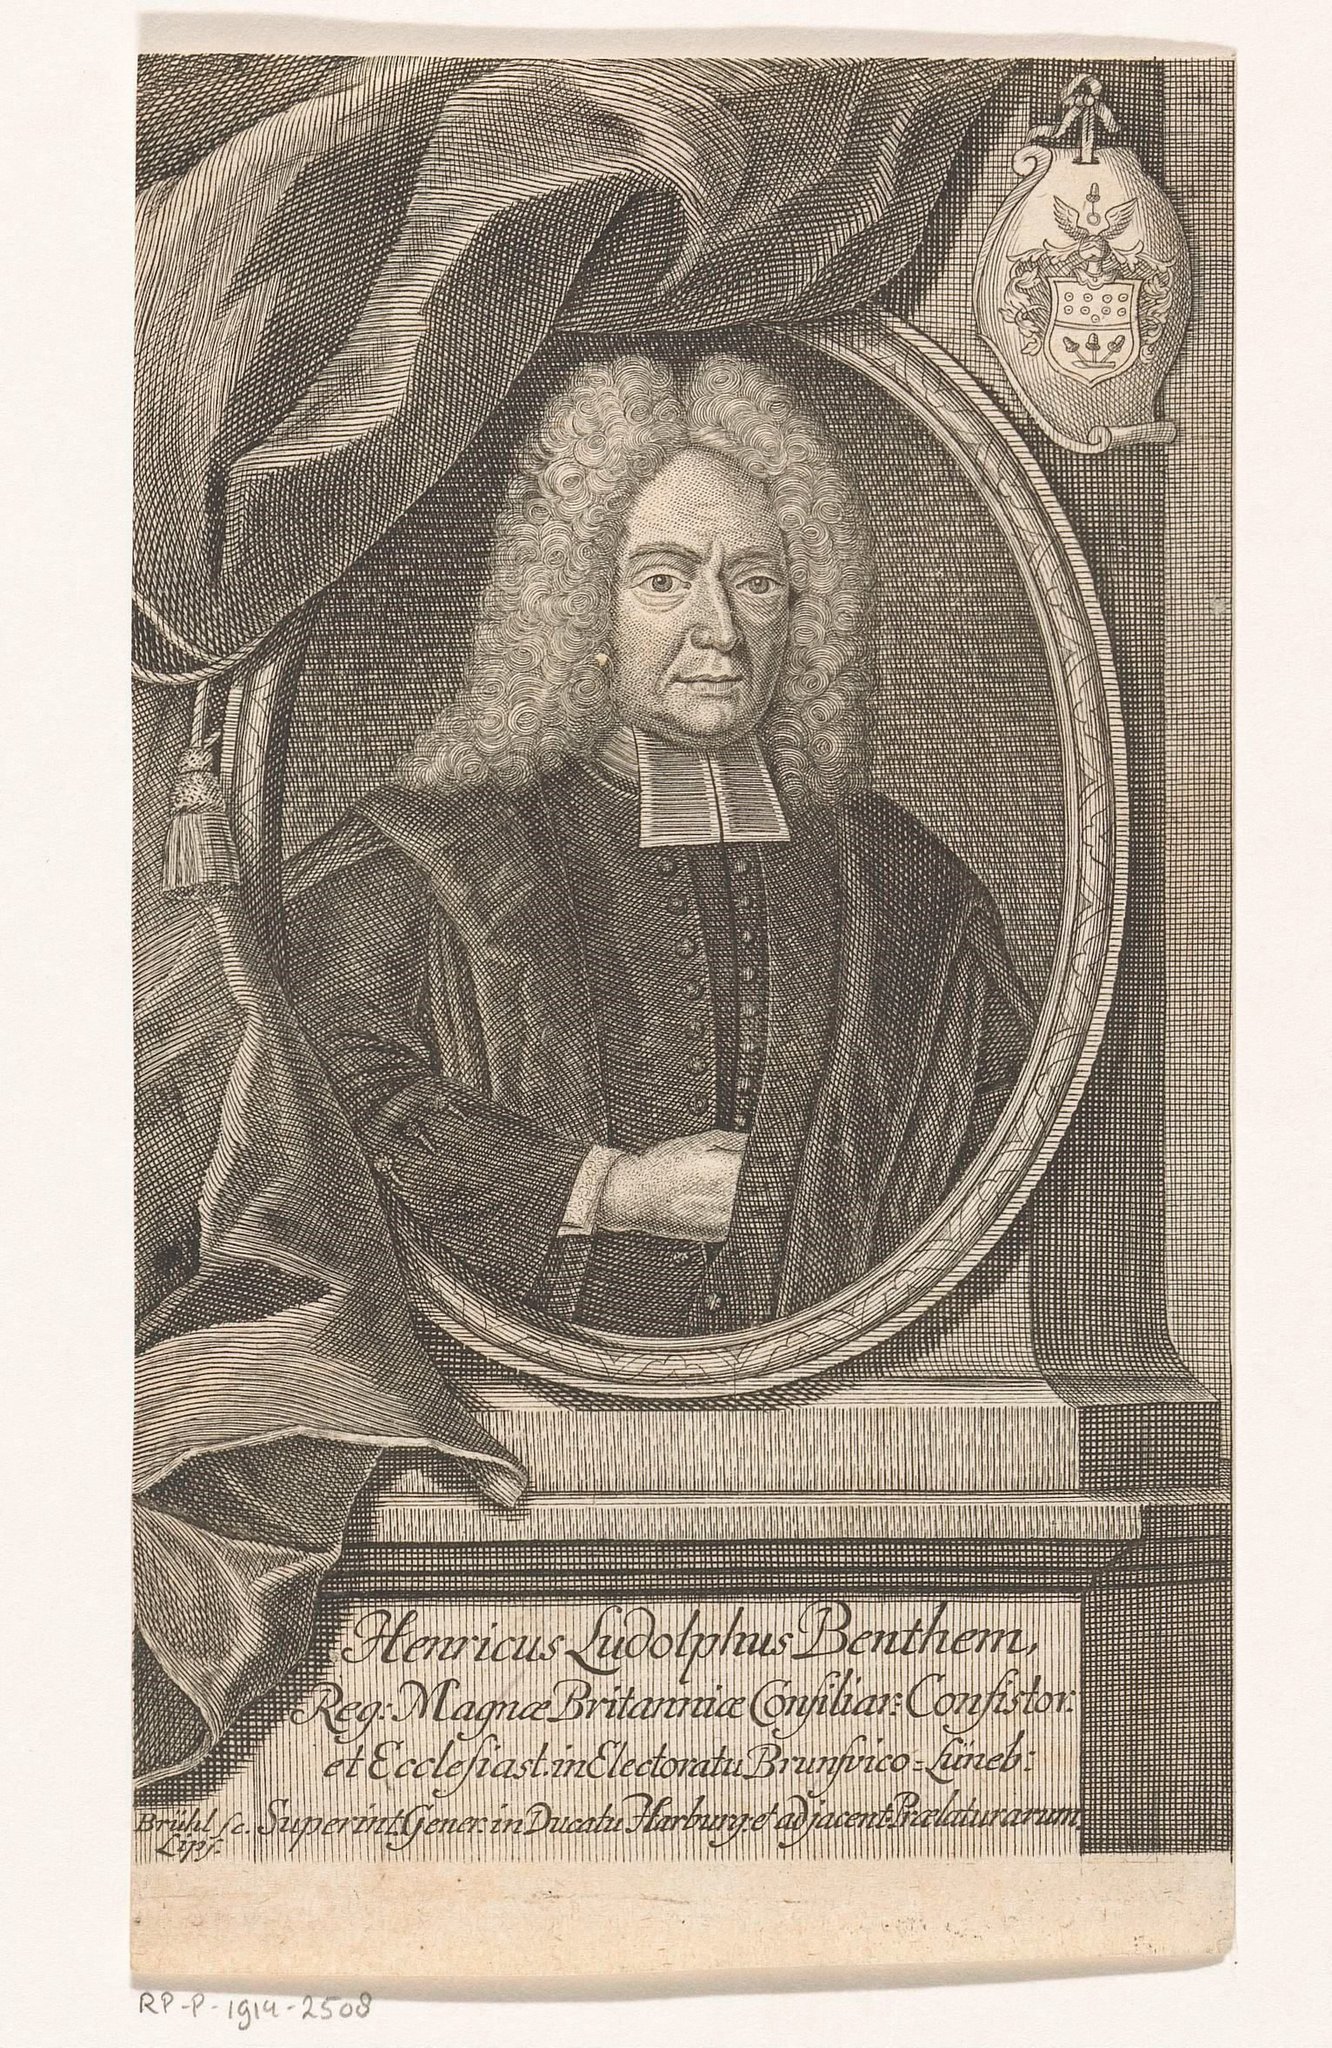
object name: print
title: Portret van Heinrich Ludolph Benthem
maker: johann benjamin brühl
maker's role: print maker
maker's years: 1691-1763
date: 1732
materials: paper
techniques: engraving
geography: leipzig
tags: historical persons, armorial bearing, heraldry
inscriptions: collector's mark: Lugt 2228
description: Prent ook gebruikt in: Benthem, Heinrich Ludolph. Neu-eröffneter Engeländischer Kirch- und Schulen-Staat (...). Leipzig: erven Philipp Gottfried Saurmann, 1732.